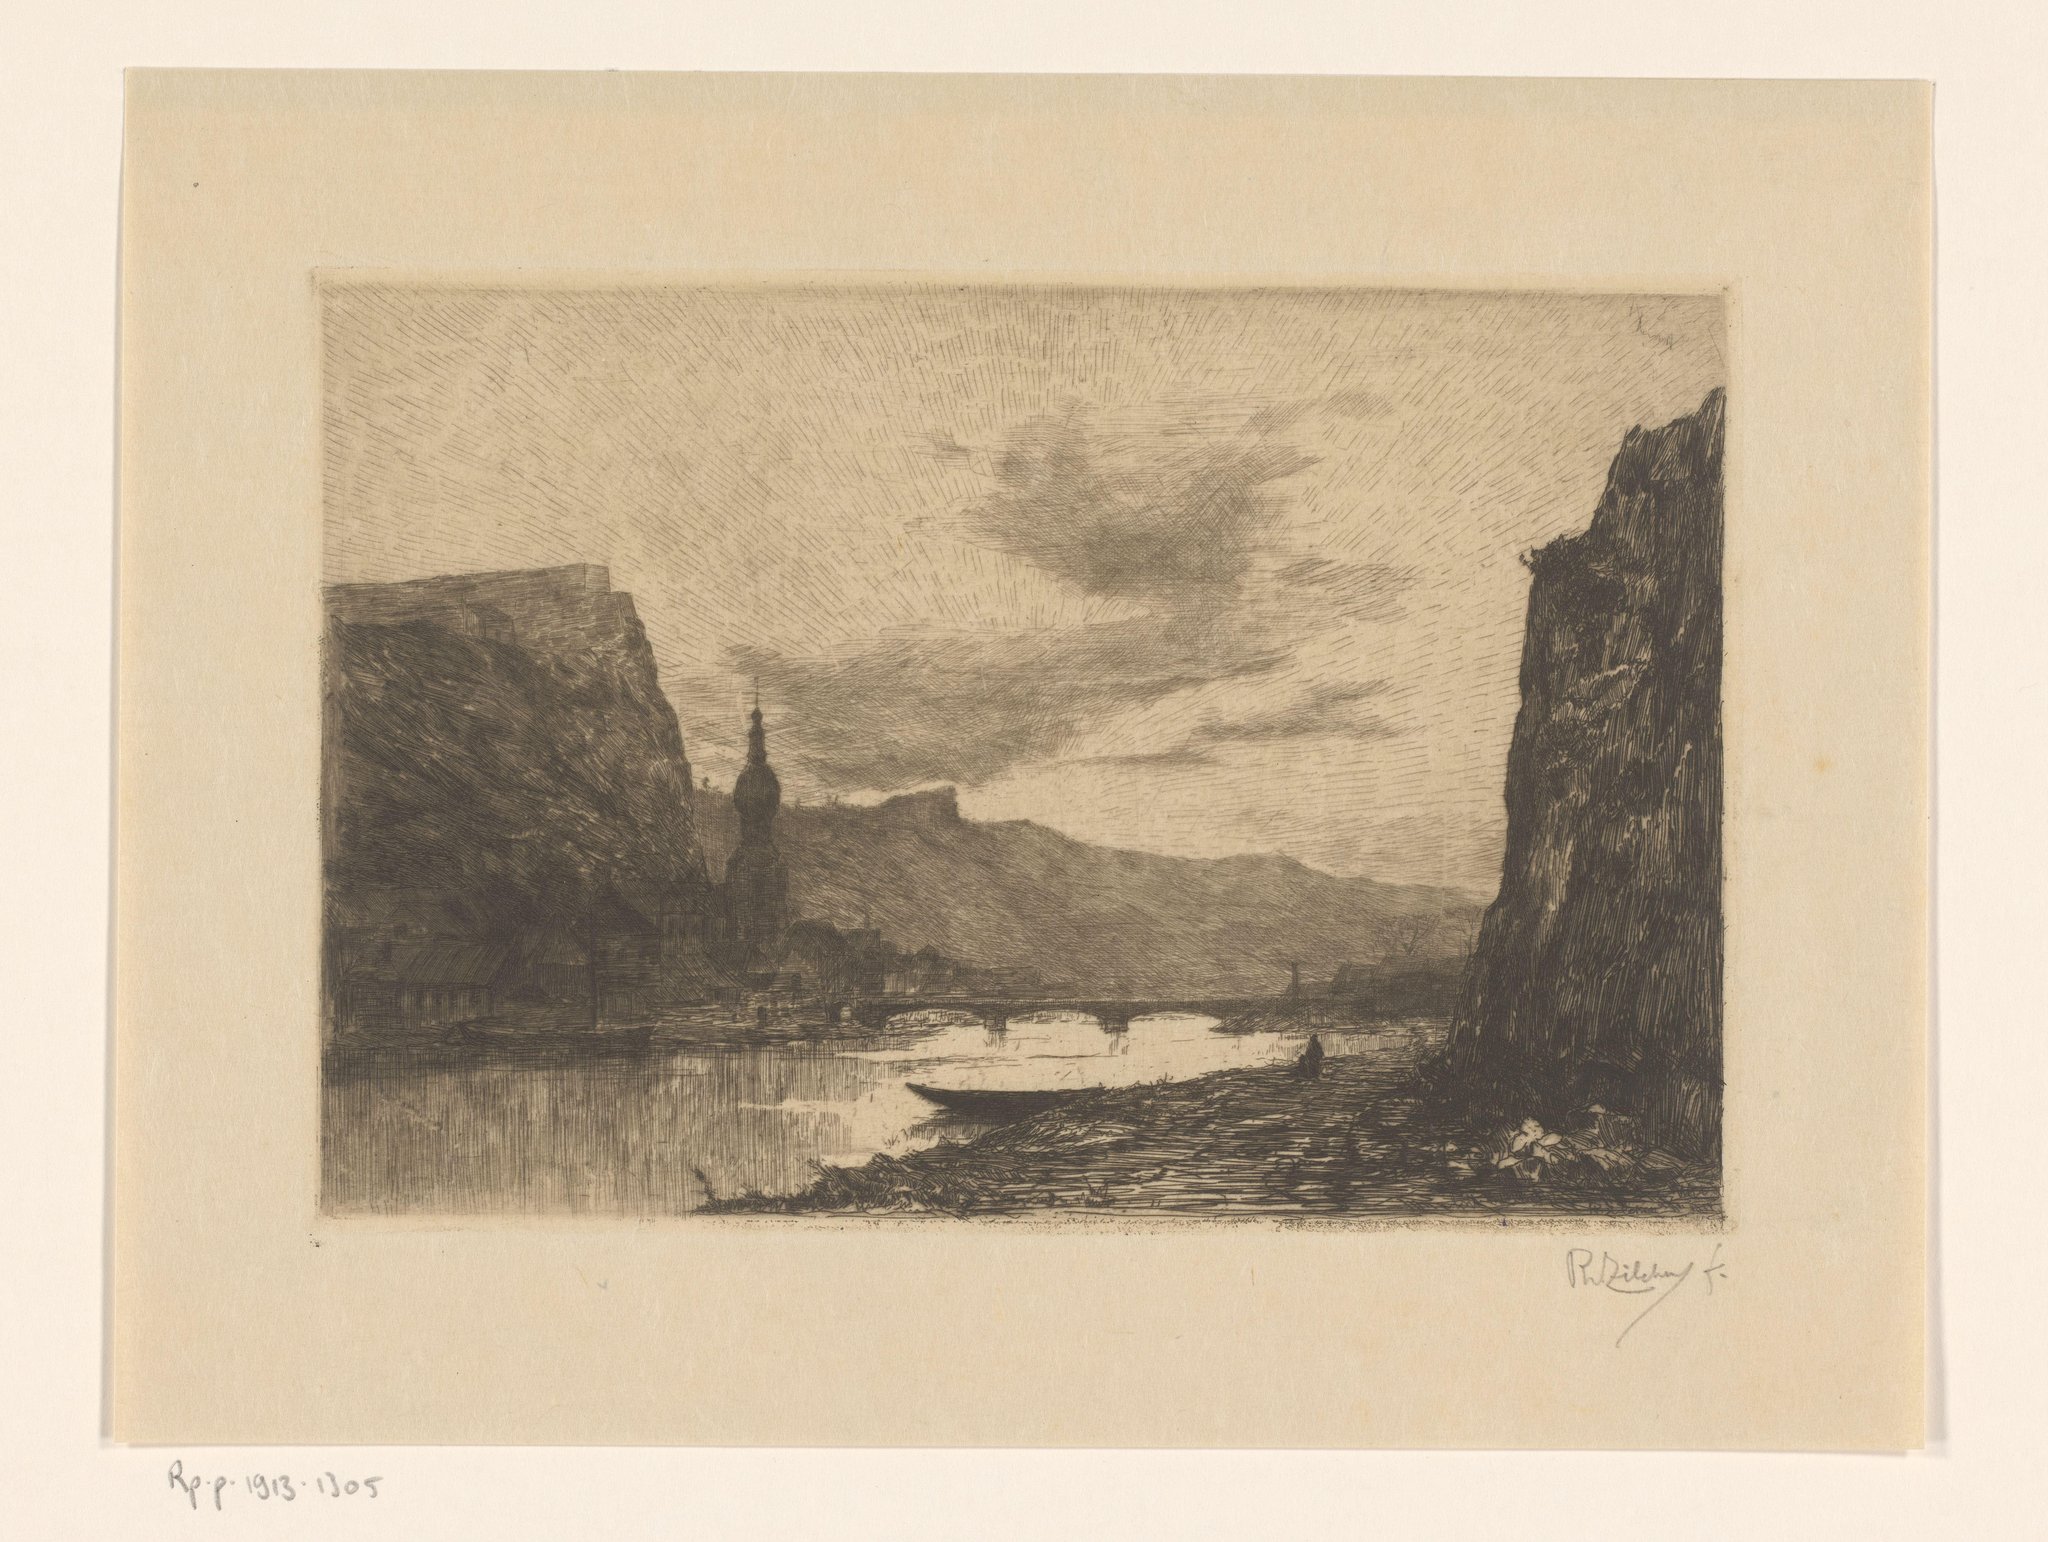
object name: print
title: Souvenir de Dinant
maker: philip zilcken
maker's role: draughtsman, painter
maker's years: 1857-1930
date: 1867-1890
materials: paper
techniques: drypoint, etching, intaglio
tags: river, prospect of city, town panorama, silhouette of city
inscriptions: collector's mark: Lugt 2233